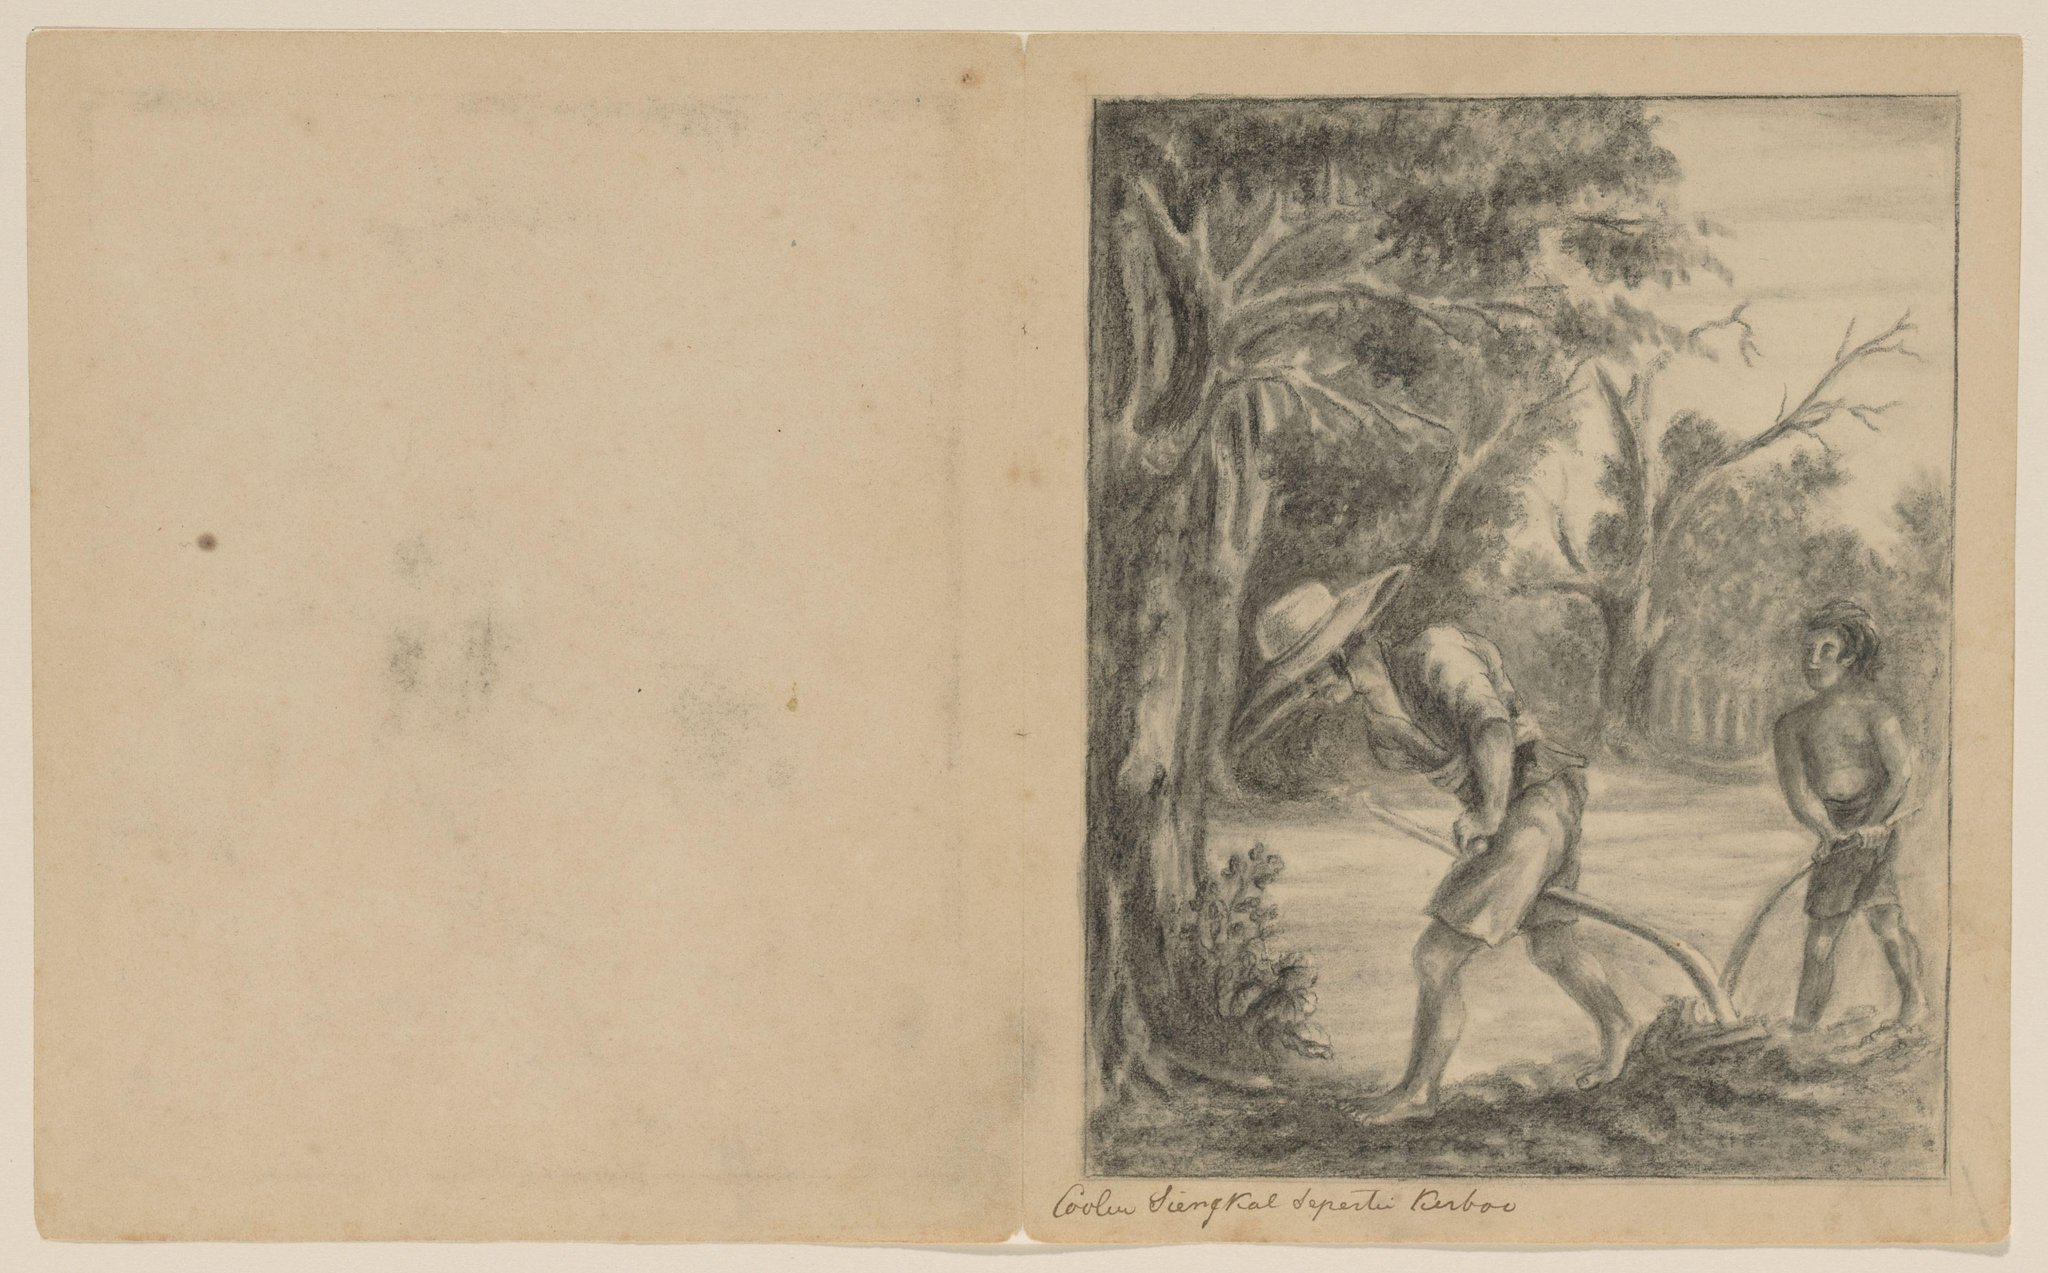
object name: drawing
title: Coolen trekt de ploeg, ca. 1820-1850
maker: Anonymous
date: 1850-1950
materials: chalk, paper, pencil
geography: indonesia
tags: coenraad laurens coolen, oost-java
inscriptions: collector's mark: Lugt 2228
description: Coolen trekt net als een karbauw de ploeg. Onderdeel van een groep van twaalf losse bladen uit een schetsboek met tekeningen over het leven van Coenraad Laurens Coolen, evangelist op Oost-Java, ca. 1820-1850. Elk blad heeft een tekening op de rechterhelft, met een onderschrift in het Indonesisch.